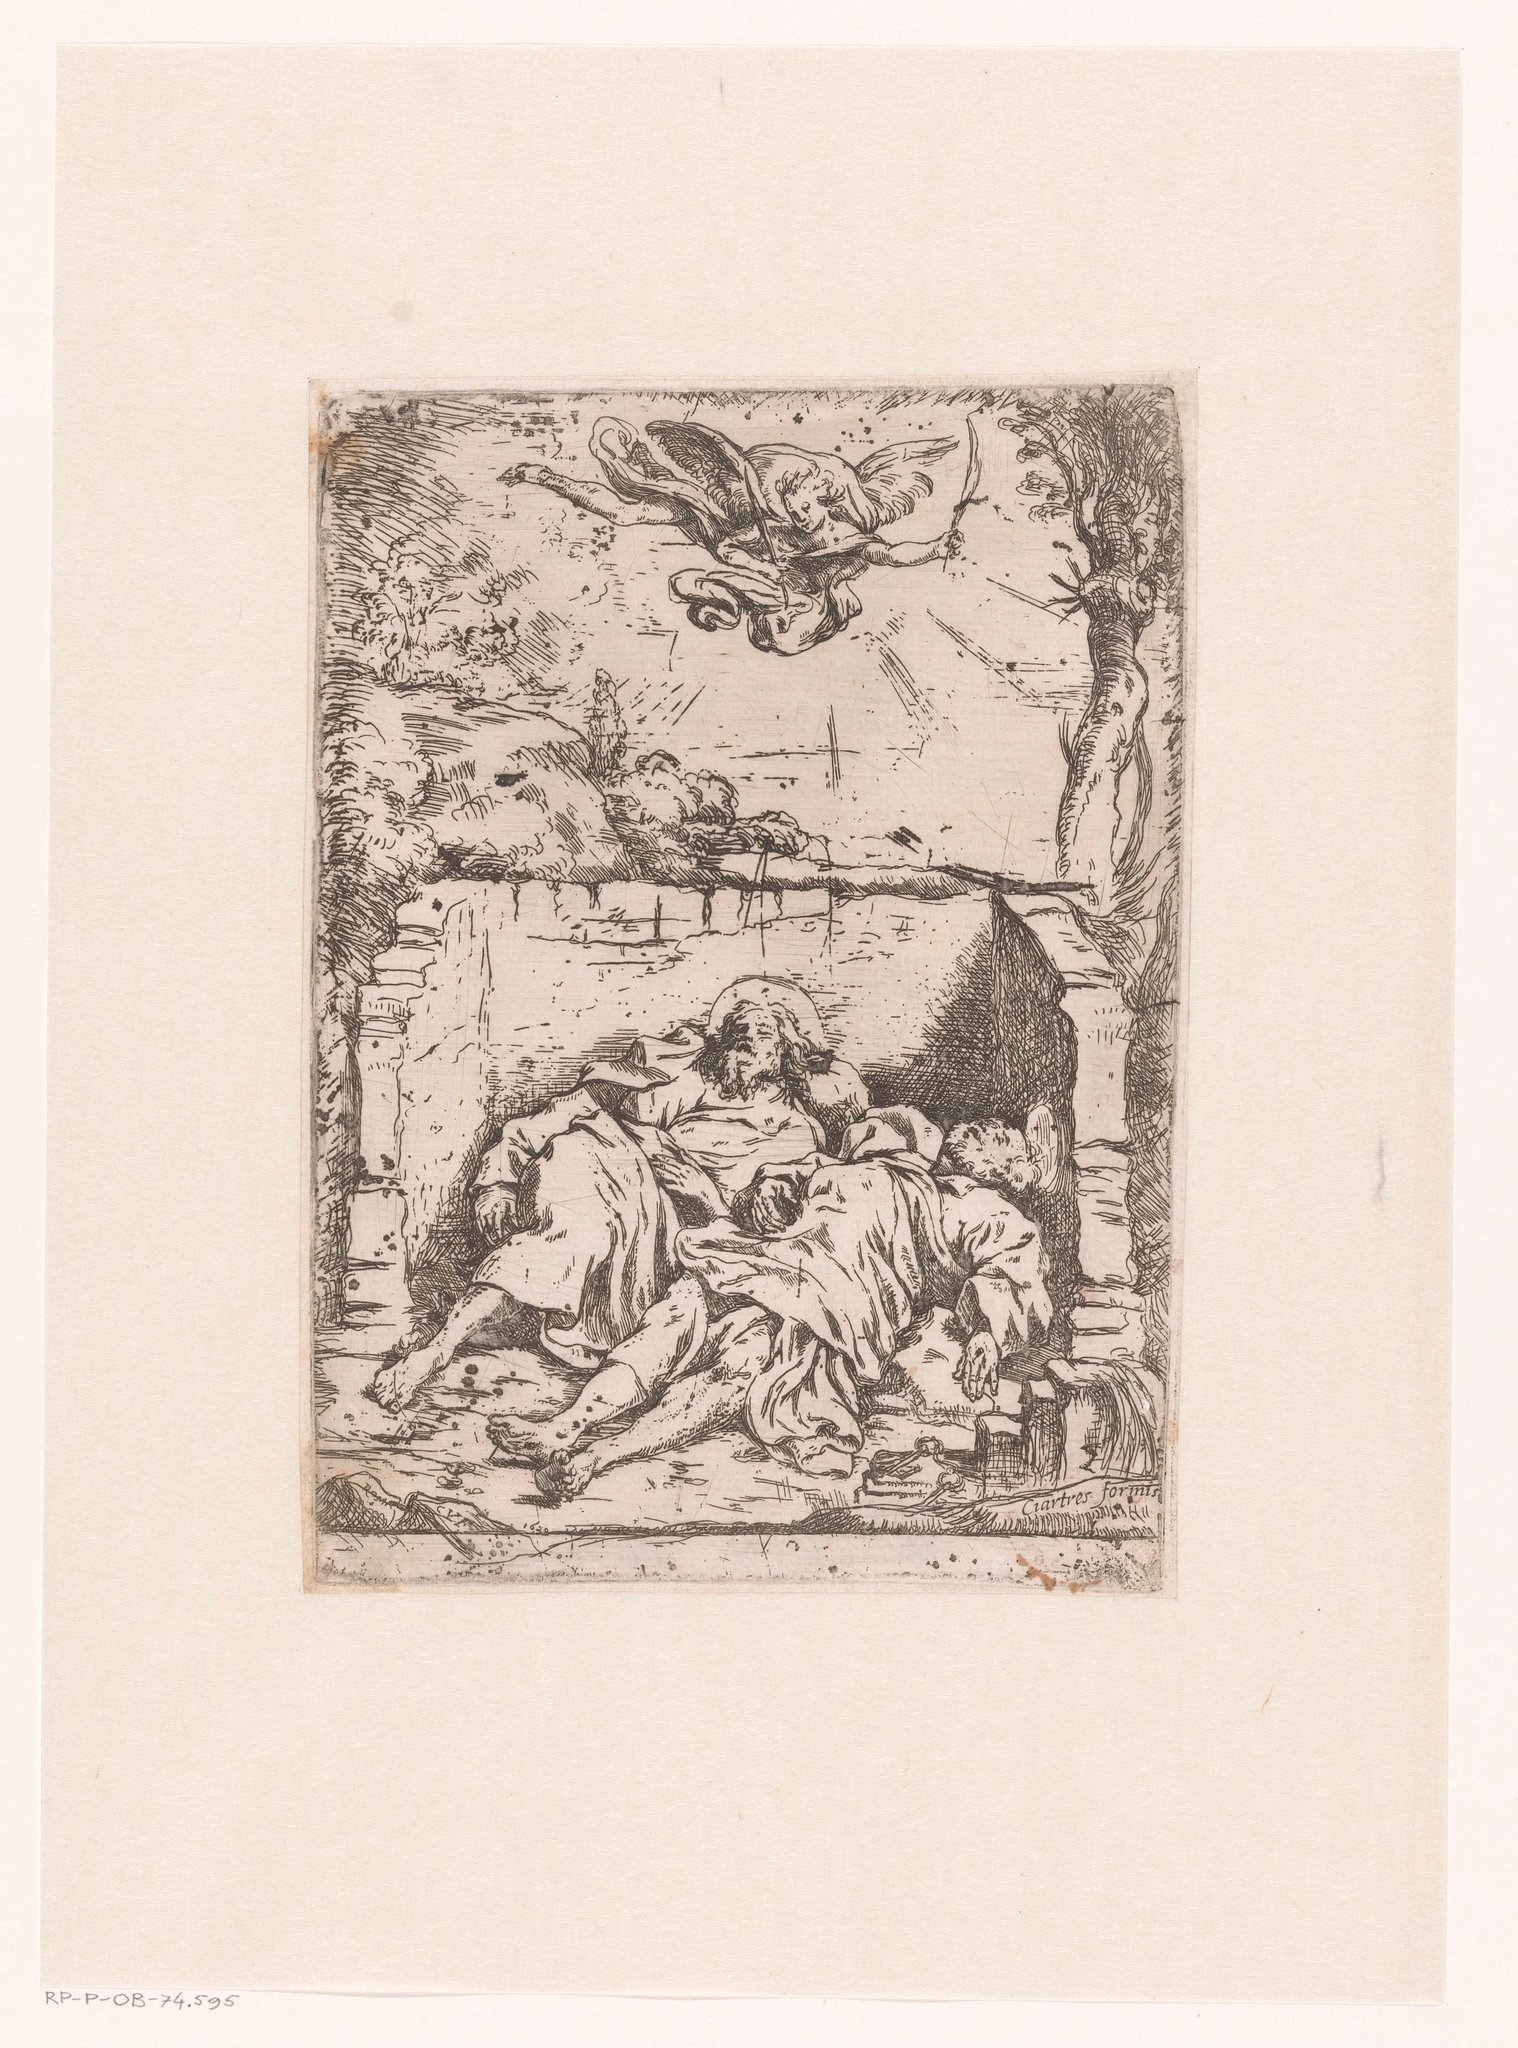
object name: print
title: Petrus en Paulus in hun tombe, een engel met palmtakken boven hun hoofd vliegend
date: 1620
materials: paper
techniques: etching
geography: paris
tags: angels crowning and/or bringing palm-branches, martyrdom and death of peter, martyrdom and death of paul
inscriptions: collector's mark: Lugt 240